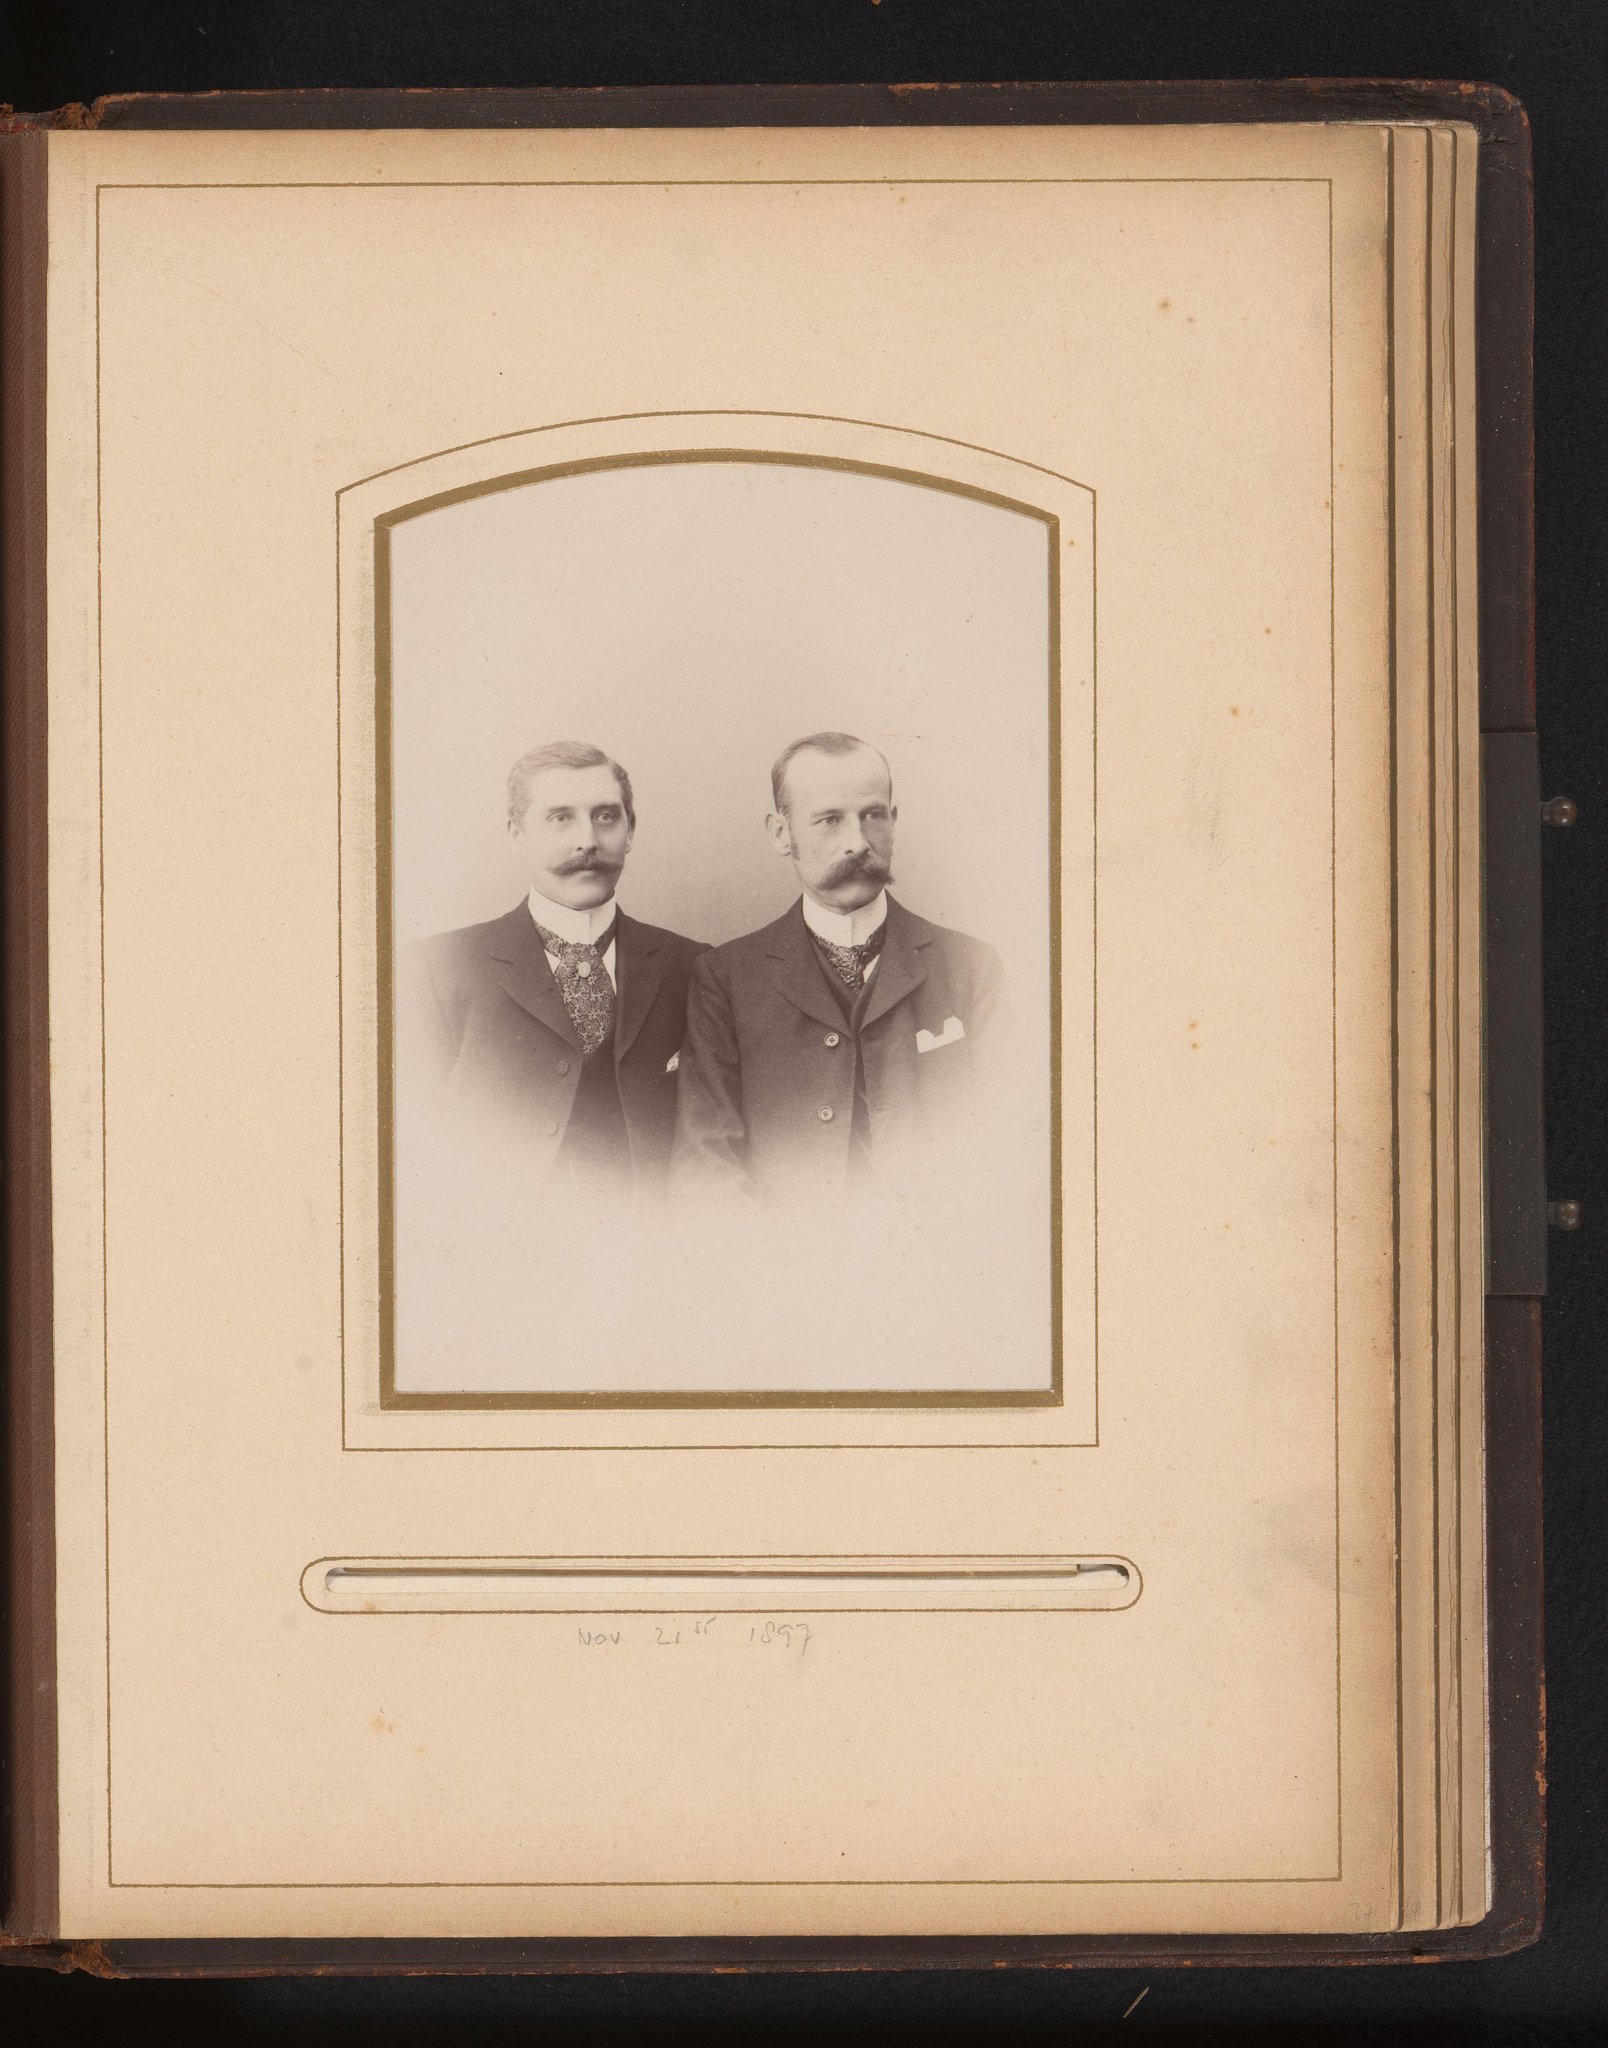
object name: photograph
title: Portret van twee mannen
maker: e. schlenker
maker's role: fotograaf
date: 1897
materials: cardboard, photographic support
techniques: albumen print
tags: moustache, adult man, historical persons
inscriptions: annotation: ‘Now, 21st, 1897’, inscription: ‘E. Schlenker Wädenswell’